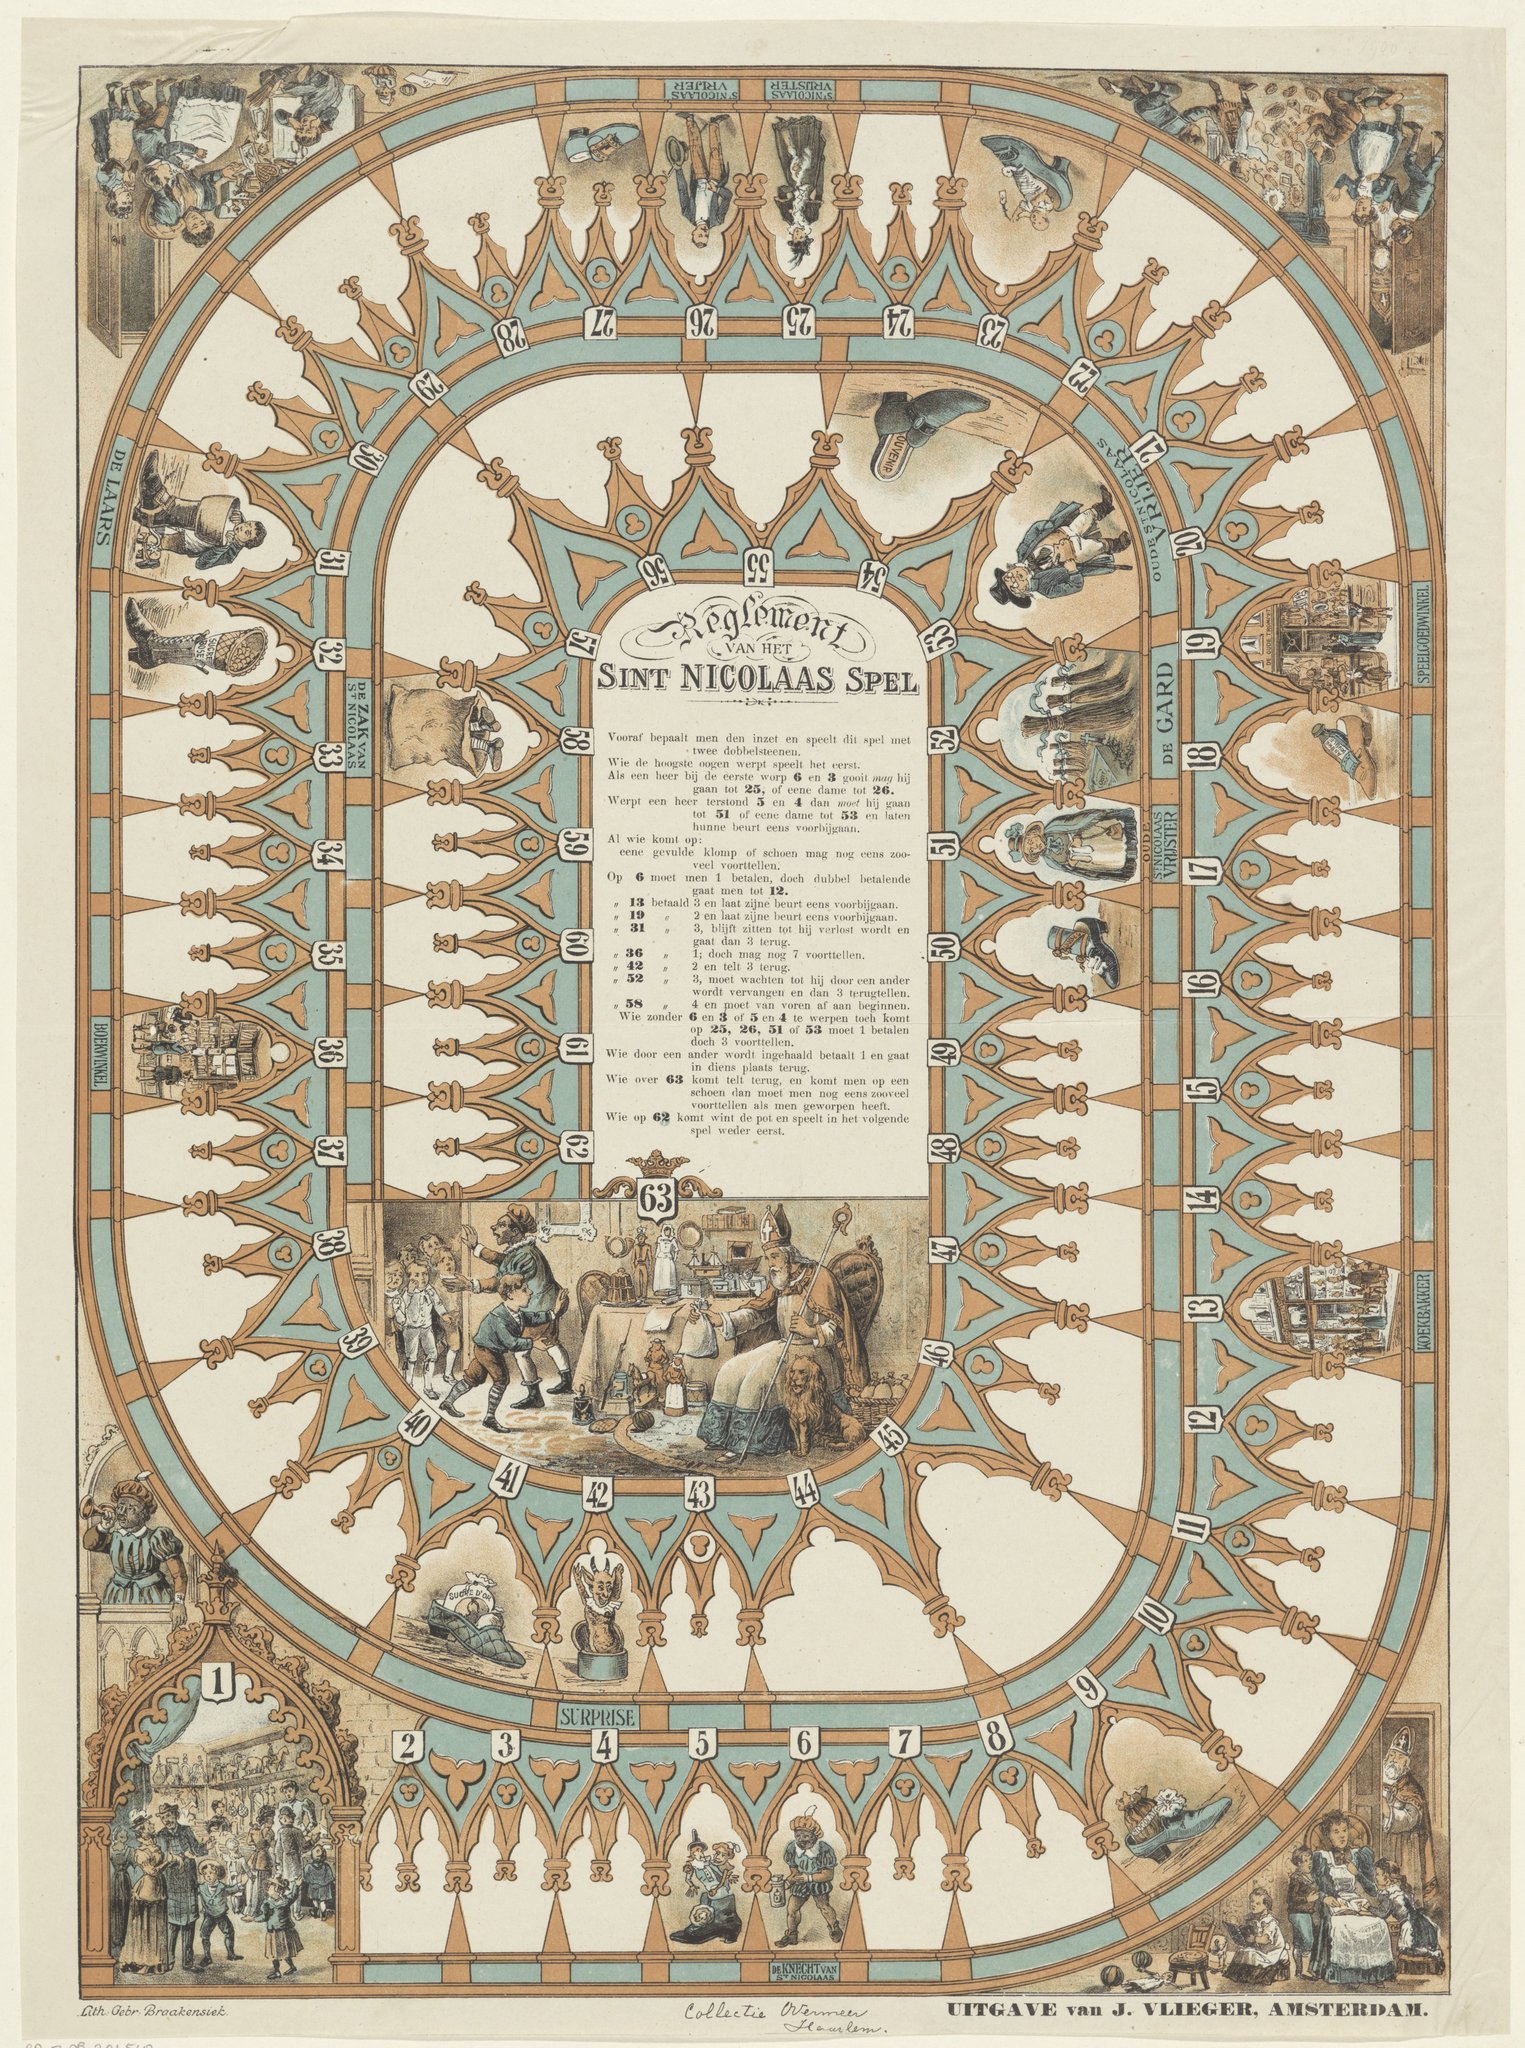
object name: gameboard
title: St Nicholas Game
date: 1885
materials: paper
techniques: colour, letterpress printing, lithograph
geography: amsterdam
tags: board-games of chance, festivities on st. nicholas (eve) (december 5), board-games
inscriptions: inscription: ‘Collectie Overmeer / Haarlem.’, collector's mark: Lugt 2760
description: This is an exceptionally fine boardgame with Gothic Revival features. Particularly instructive is the image at the ‘end’ of the game. One boy has been good and is collecting his presents from Saint Nicholas. Five others are kept outside and admonished by an obviously agitated Pete. They look in with crestfallen, and in some cases tearful, faces.